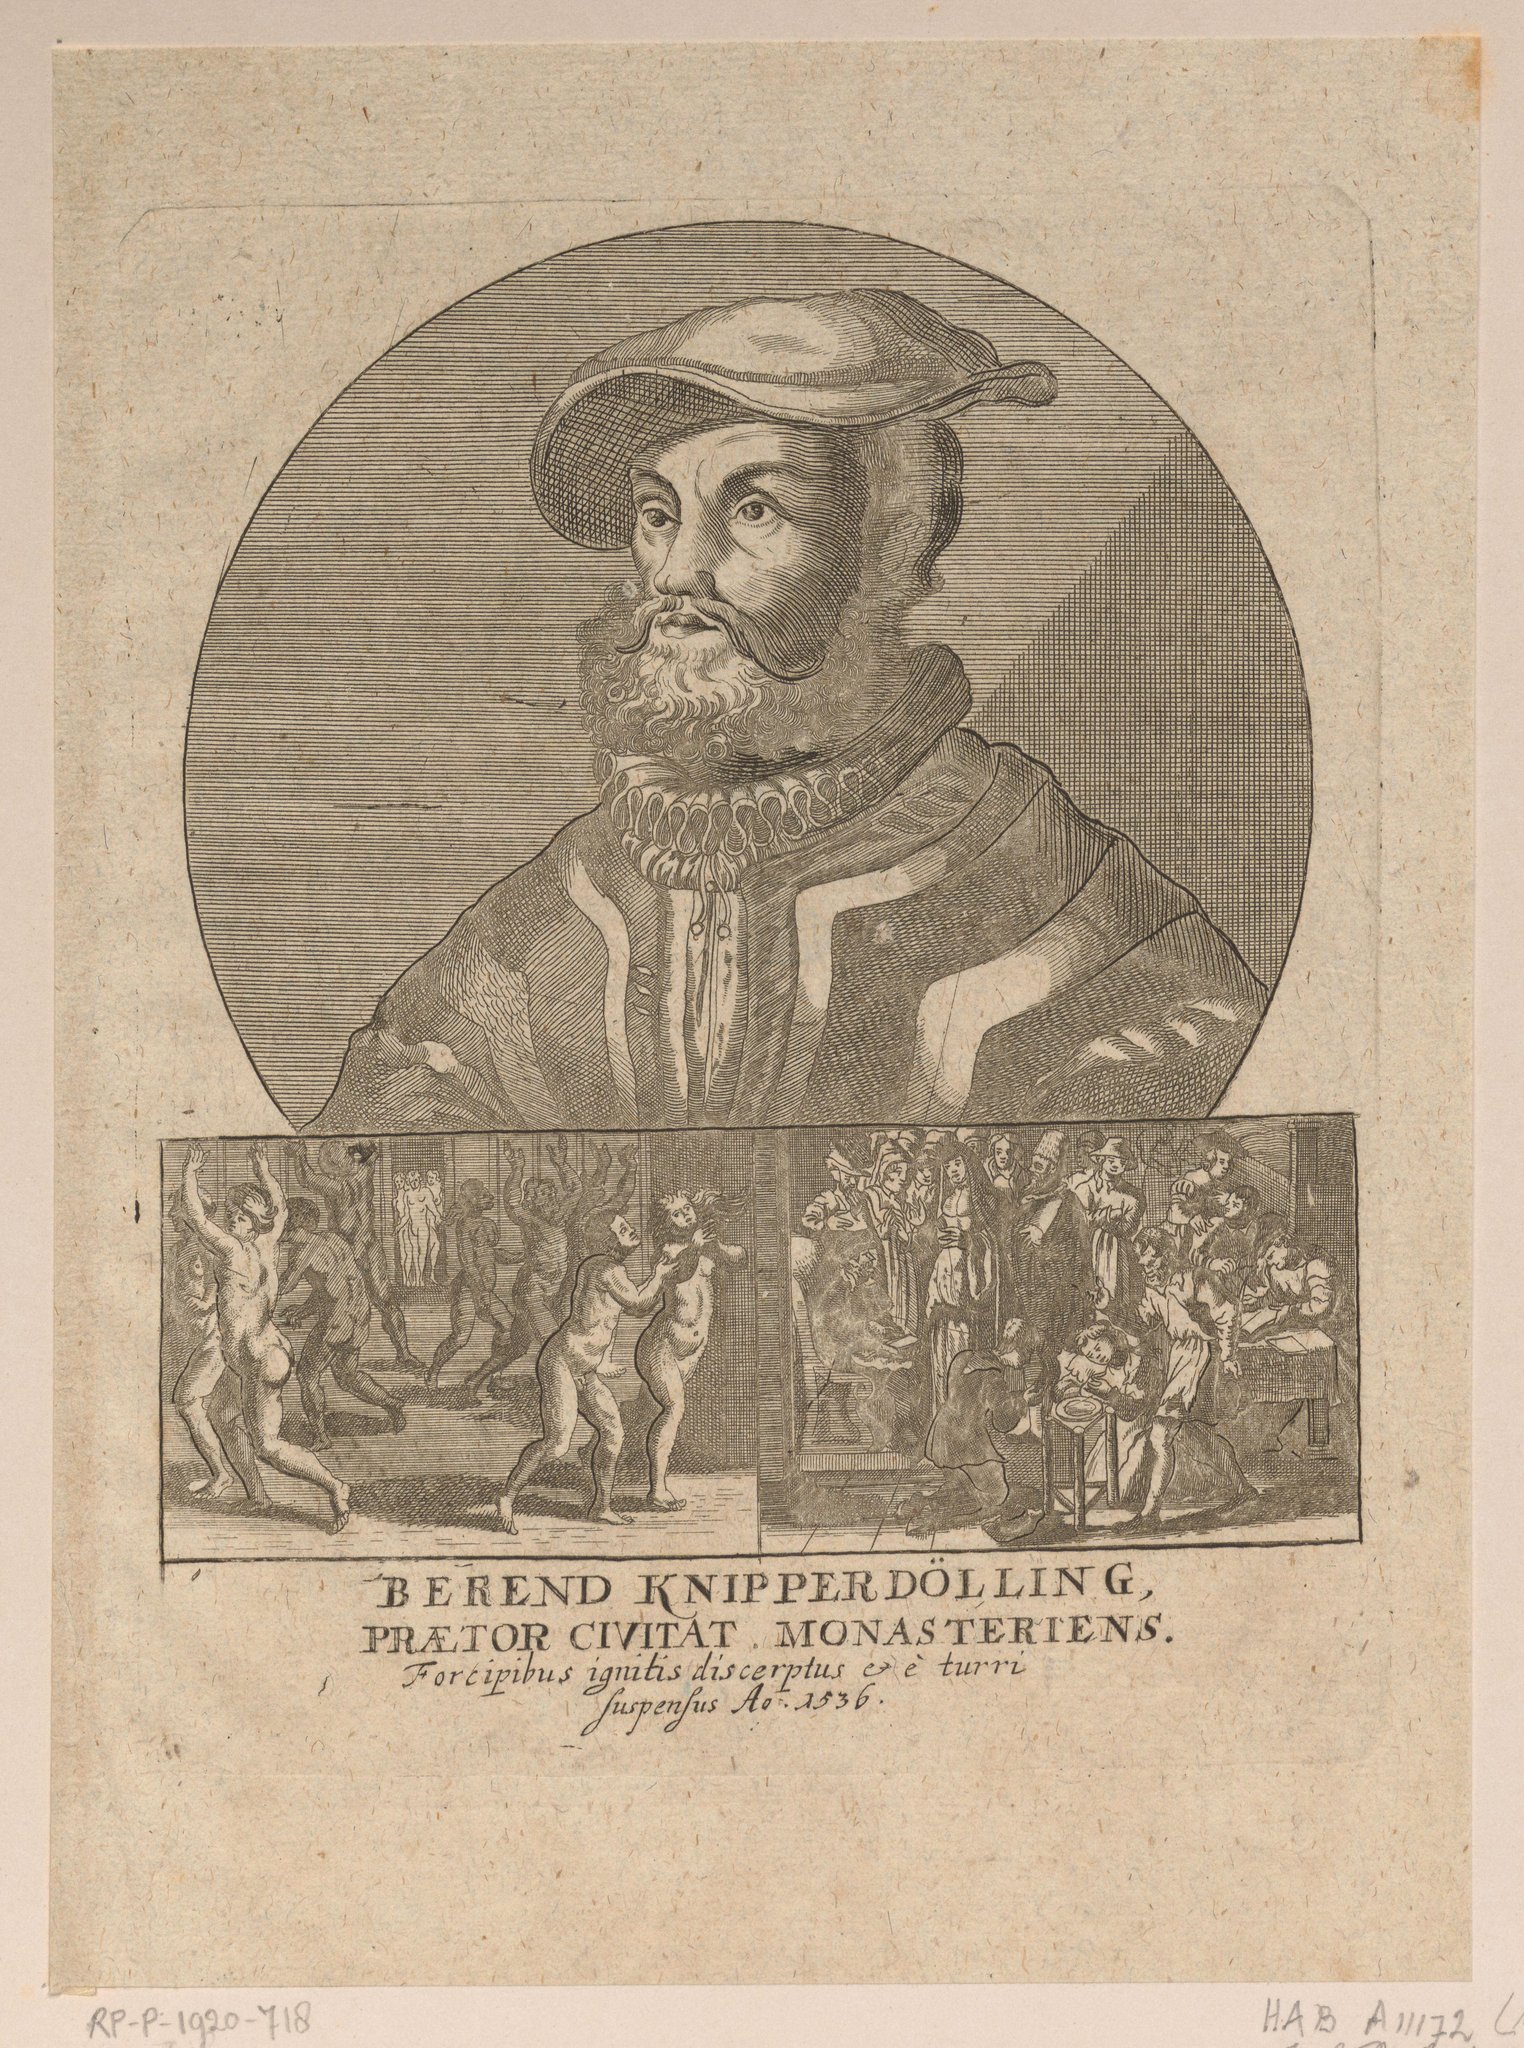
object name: print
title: Portret van Bernardus Knipperdolling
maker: Anonymous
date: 1701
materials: paper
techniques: engraving, etching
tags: historical persons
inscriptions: collector's mark: Lugt 2228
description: Prent mogelijk uit: Theobald, Zacharias. Der Alten und Neuen Schwärmer, Widertäufferischer Geist (...). Cothen: s.n., 1701.